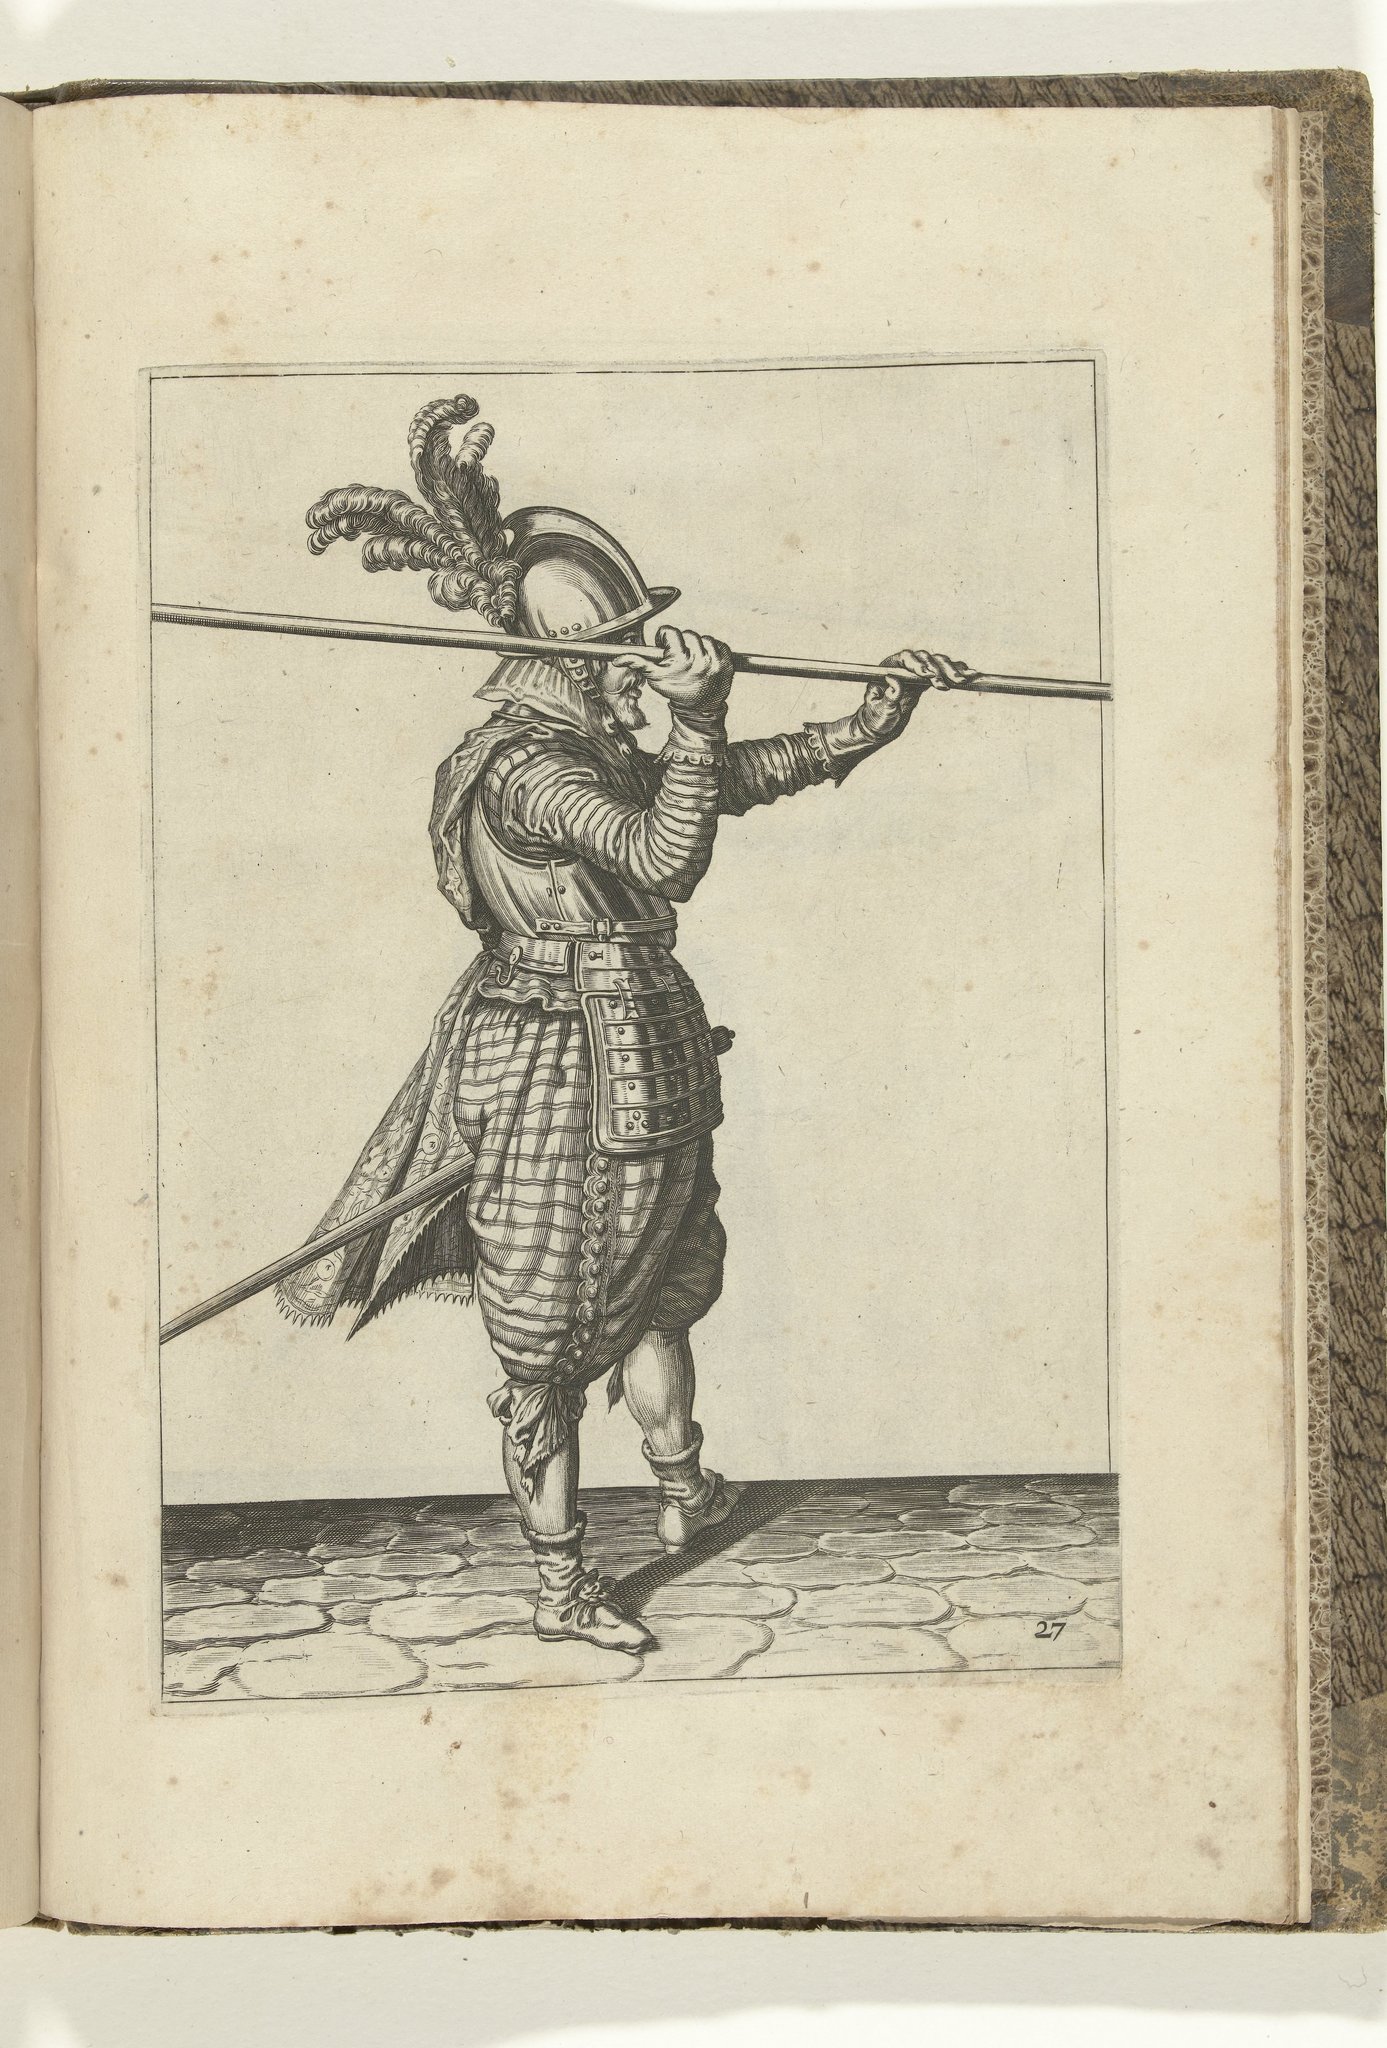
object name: print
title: Soldaat die zijn spies met beide handen horizontaal boven zijn rechterschouder tilt (nr. 27), ca. 1600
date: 1597-1608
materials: paper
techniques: engraving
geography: amsterdam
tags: the hague, maurice (prince of orange), handling of weapons ~ military training, weapons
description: Een soldaat, ten voeten uit, naar rechts, die een spies (lans) met beide handen horizontaal boven zijn rechterschouder tilt (nr. 27), ca. 1600. Plaat 27 in de instructies voor het hanteren van de spies: Enseignement brief; et succint sur les portraitz figurez, touchant l'usage, de tout ce qu'un Soldat doibt faire au maniement de la Pique. Onderdeel van de illustraties in een Franse editie van J. de Gheyns Wapenhandelinghe: J. de Gheyn, Maniement d'armes, d'arquebuses, mousquetz et piques : en conformité de l'ordre de Mour le Prince Maurice, Prince d'Orange, Amsterdam 1608. Krijgswezen rond 1600.